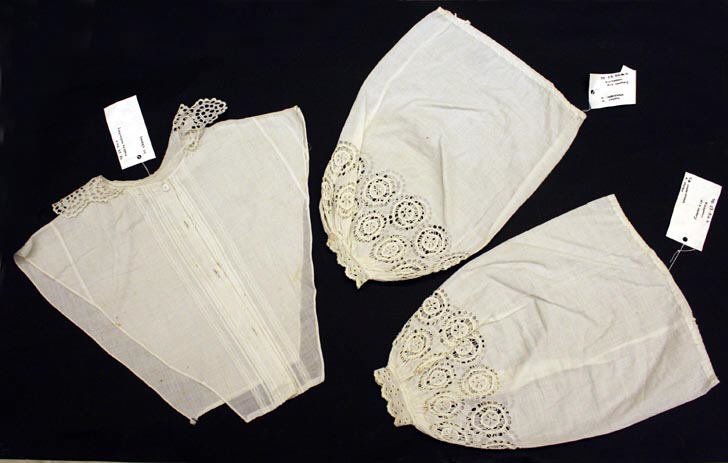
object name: accessory set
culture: european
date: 1834-1866